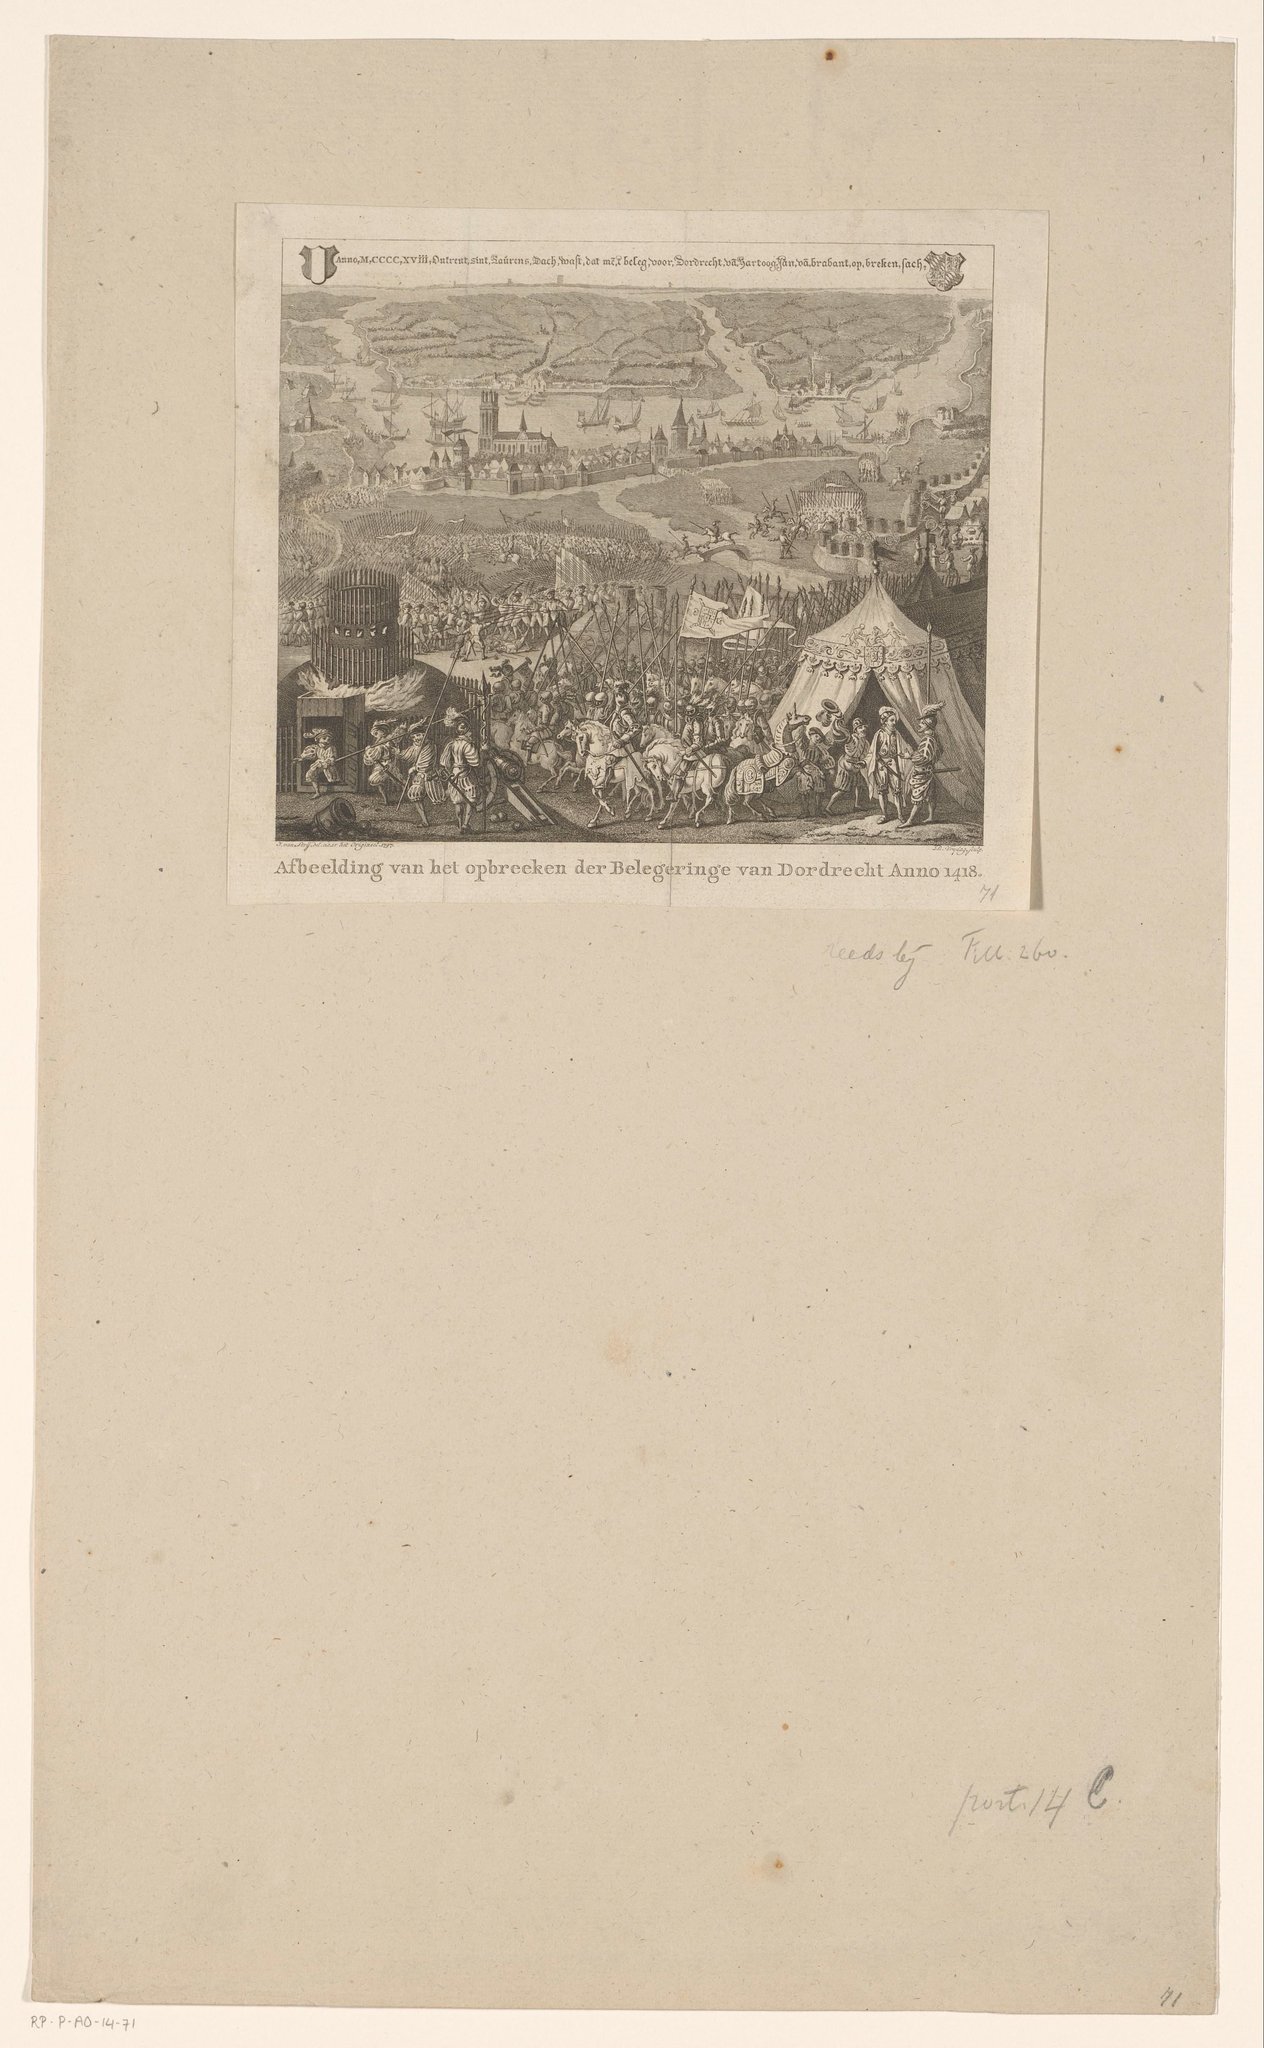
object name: print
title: Afbeelding van het opbreeken der Belegeringe van Dordrecht anno 1418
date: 1797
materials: paper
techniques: engraving, etching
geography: netherlands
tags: coat of arms (as symbol of the state, etc.) (+ city; municipal), siege, position war, armorial bearing, heraldry, dordrecht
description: Het opbreken van het Beleg van Dordrecht, 8 augustus 1418. Kopie naar een oud schilderij op het Raadhuis van Dordrecht. Op de voorgrond het legerkamp van de belegeraars, daarachter schermutselingen, in de verte de stad Dordrecht. Boven de voorstelling de oorspronkelijke inscriptie met links het wapen van Dordrecht en rechts dat van Jacoba of Jan VI van Beieren.